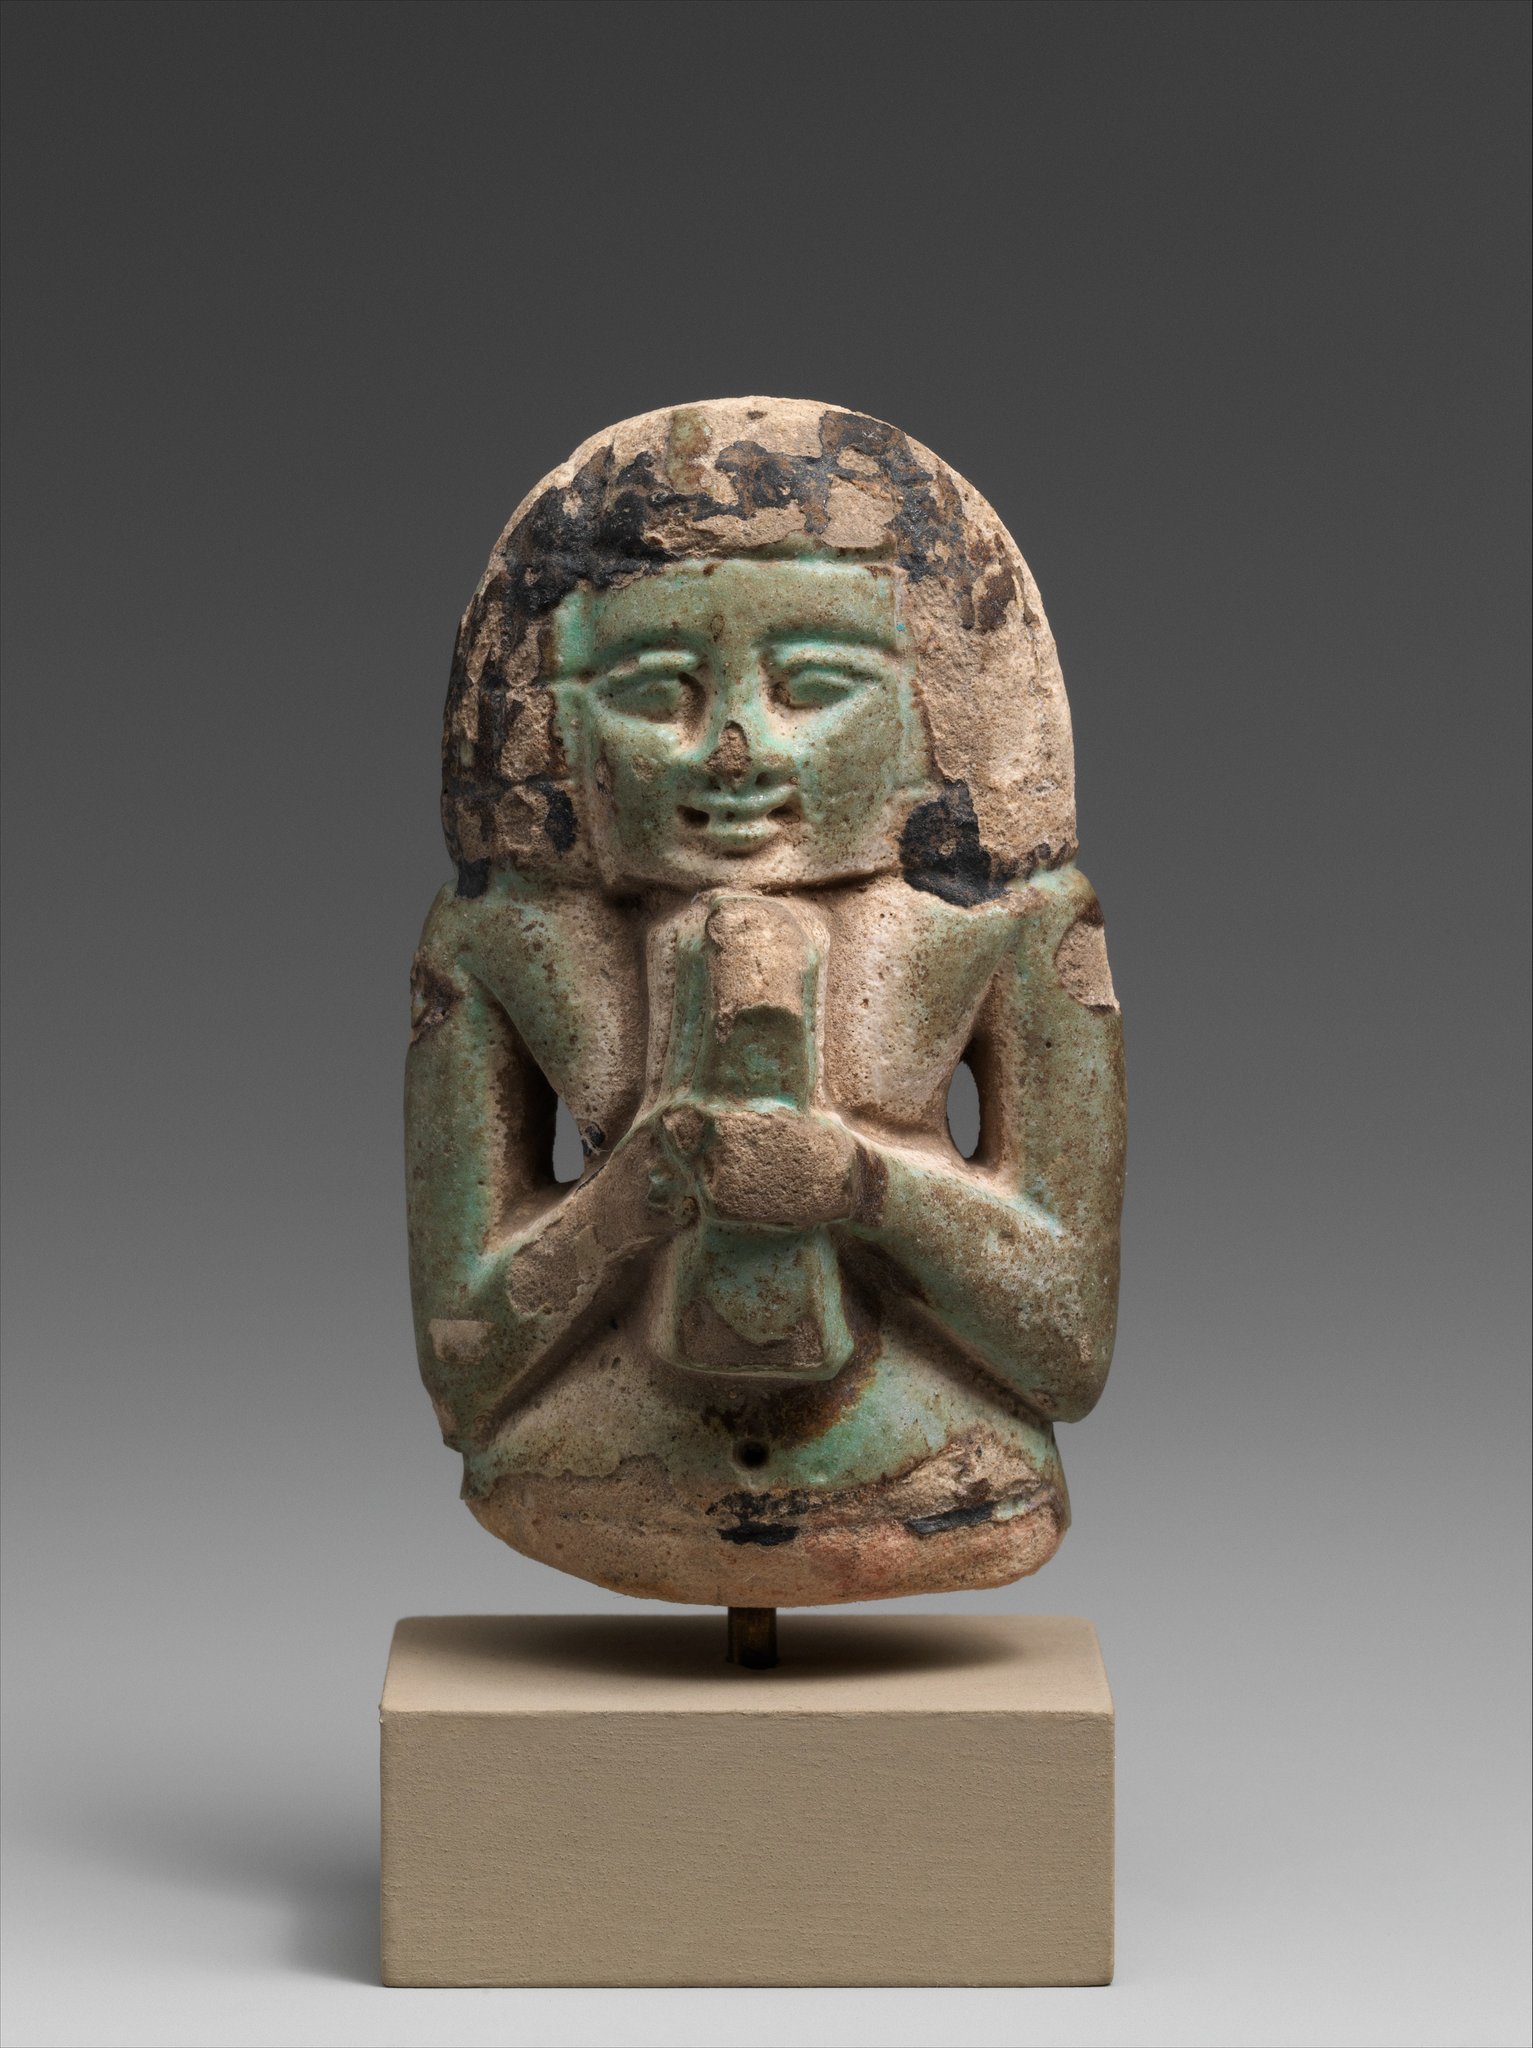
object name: figurine, woman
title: Female figure playing a lyre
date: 945-525 BCE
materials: faience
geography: egypt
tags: musical instruments,women